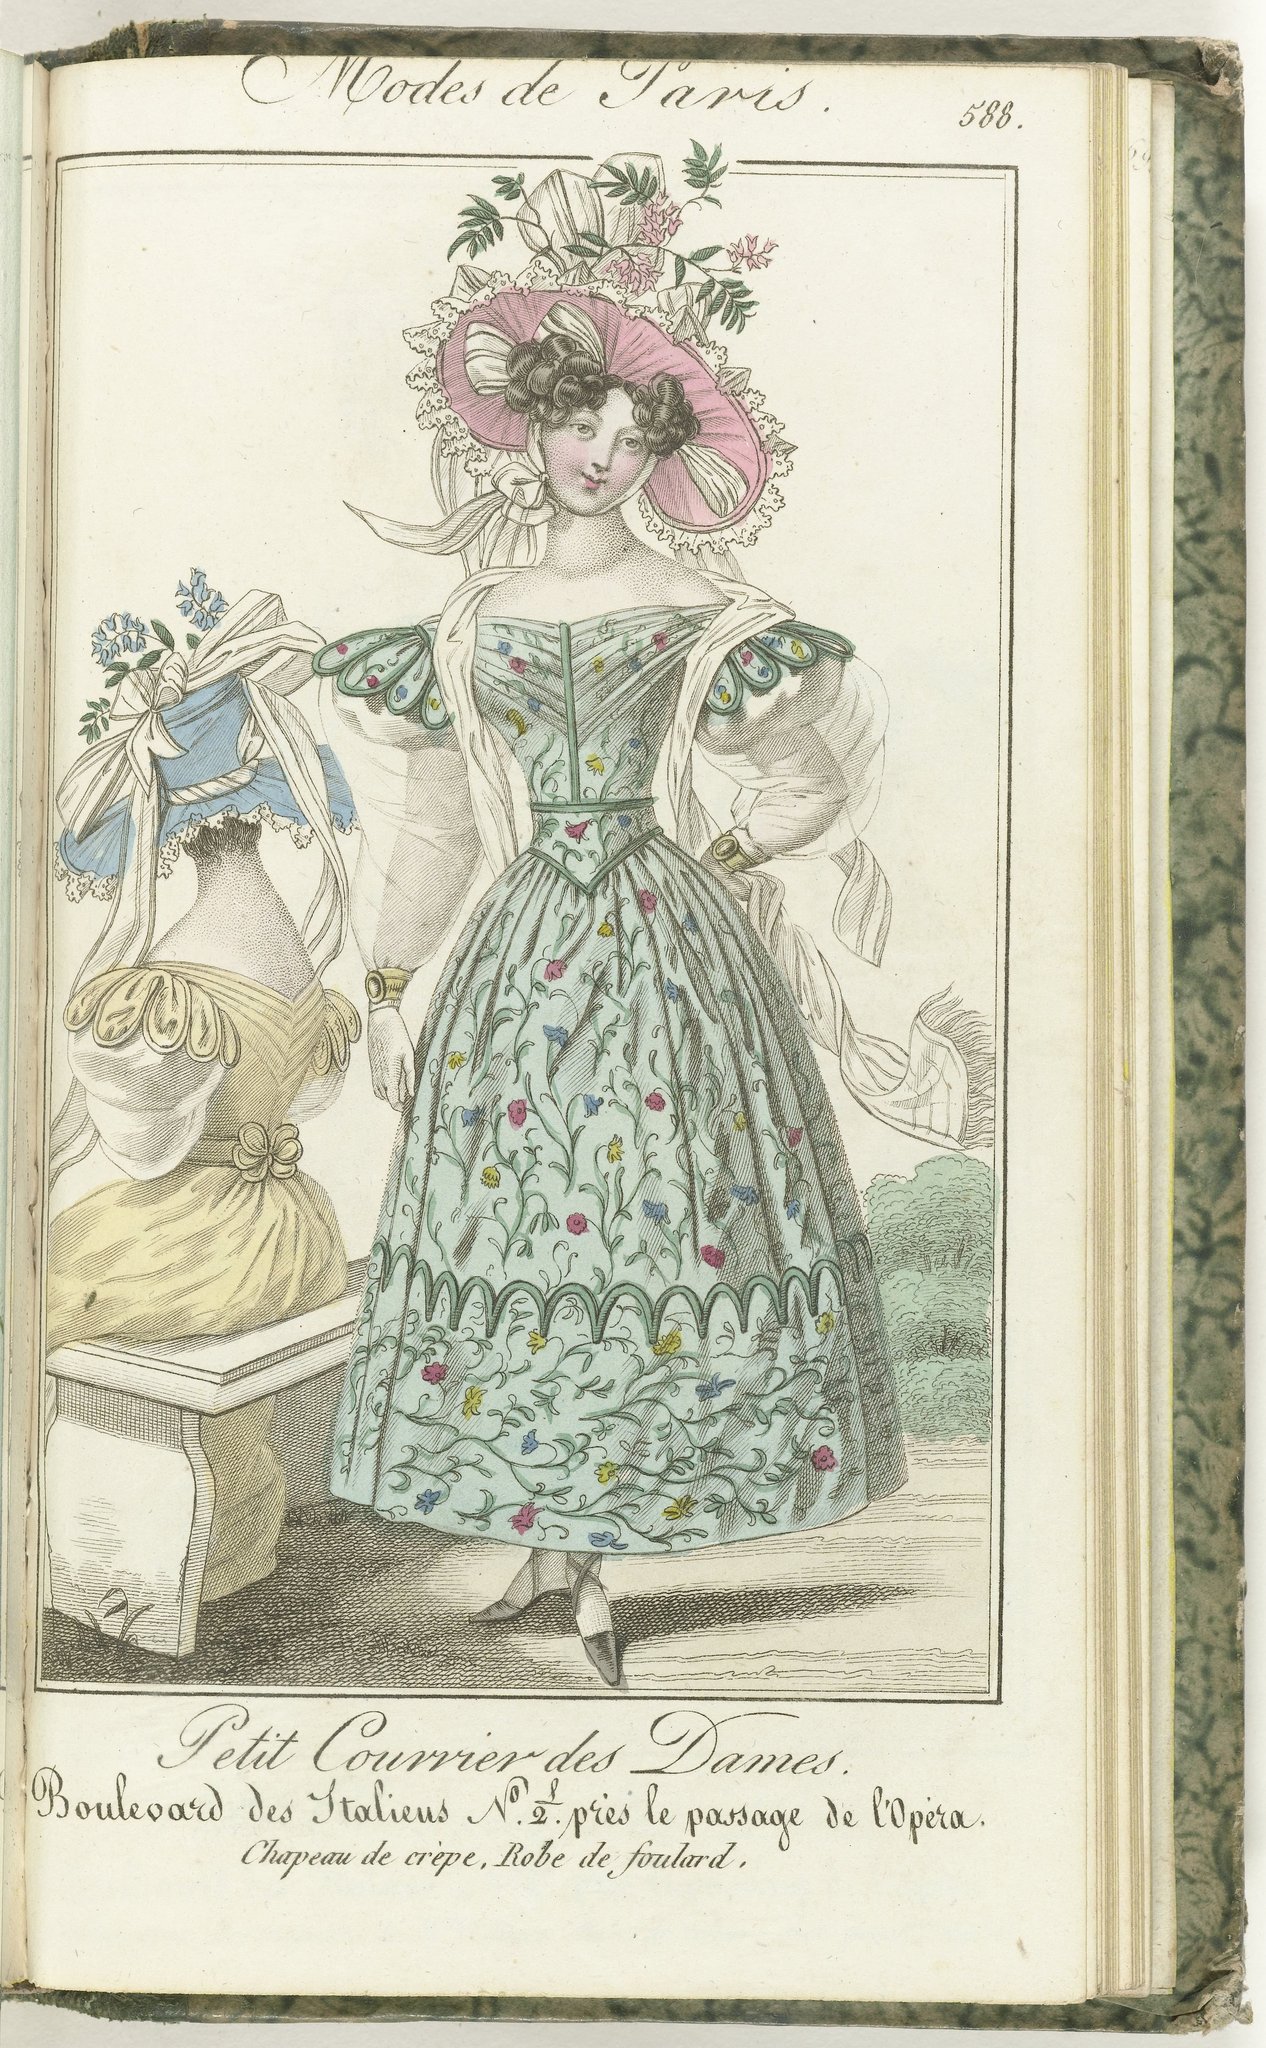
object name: fashion print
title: Petit Courrier des Dames, 1828, No. 588: Chapeau de crèpe...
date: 1828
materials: paper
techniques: engraving, hand coloring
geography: paris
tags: clothing for the upper part of the body (shawl) (+ women's clothes), fashion plates, head-gear: hat (+ women's clothes), dress, gown (+ women's clothes)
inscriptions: caption: ‘Chapeau de crèpe, Robe de foulard.’, title: ‘Modes de Paris.’, title: ‘Petit Courrier des Dames.’, address: ‘Boulevard des Italiens No.2 près le passage de l'Opèra.’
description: Staande vrouw gekleed in een japon van 'foulard' met bloemmotief. Korte pofmouwen waarover doorzichtige schapenboutmouwen. Op het hoofd een hoed van crêpe. Om de schouders een lange sjaal met aan de uiteinden franjes. Prent uit het modetijdschrift Petit Courrier des Dames (1821-1868). Ingebonden (met enkele pag. Le Journal des Dames et des Modes). 15 Januari 1827 t/m 20 maart 1830. Incompleet.